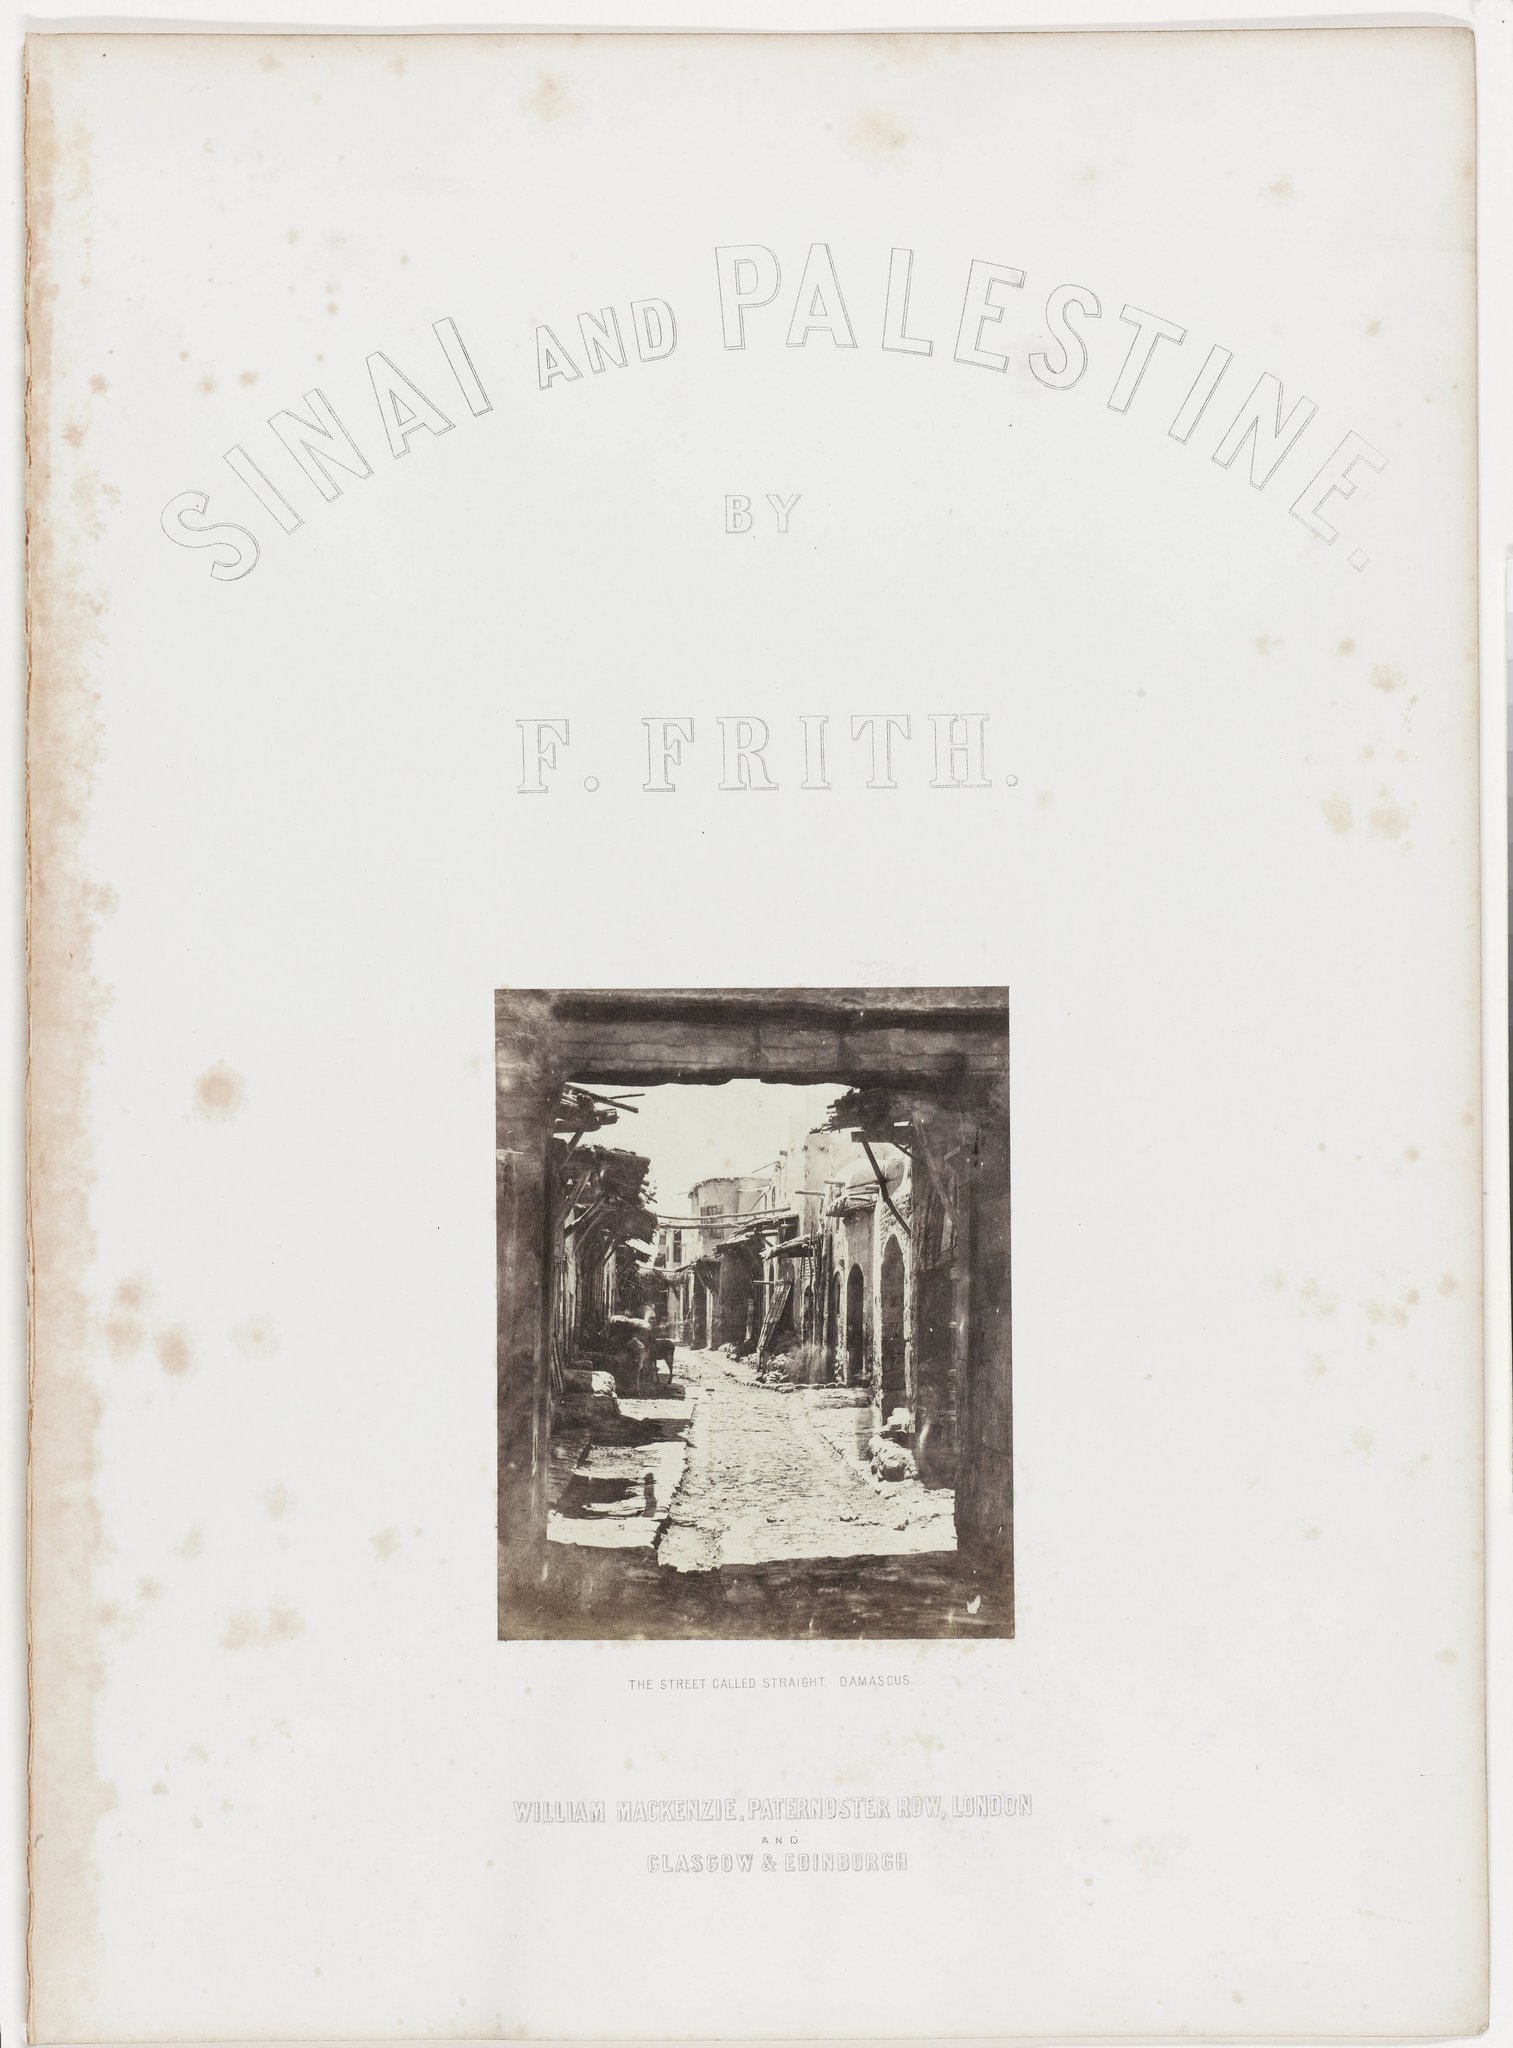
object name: photograph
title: The street called straight, Damascus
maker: francis frith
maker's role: publisher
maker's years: 1822-1898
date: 1857-1863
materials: paper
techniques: albumen print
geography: damascus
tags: street